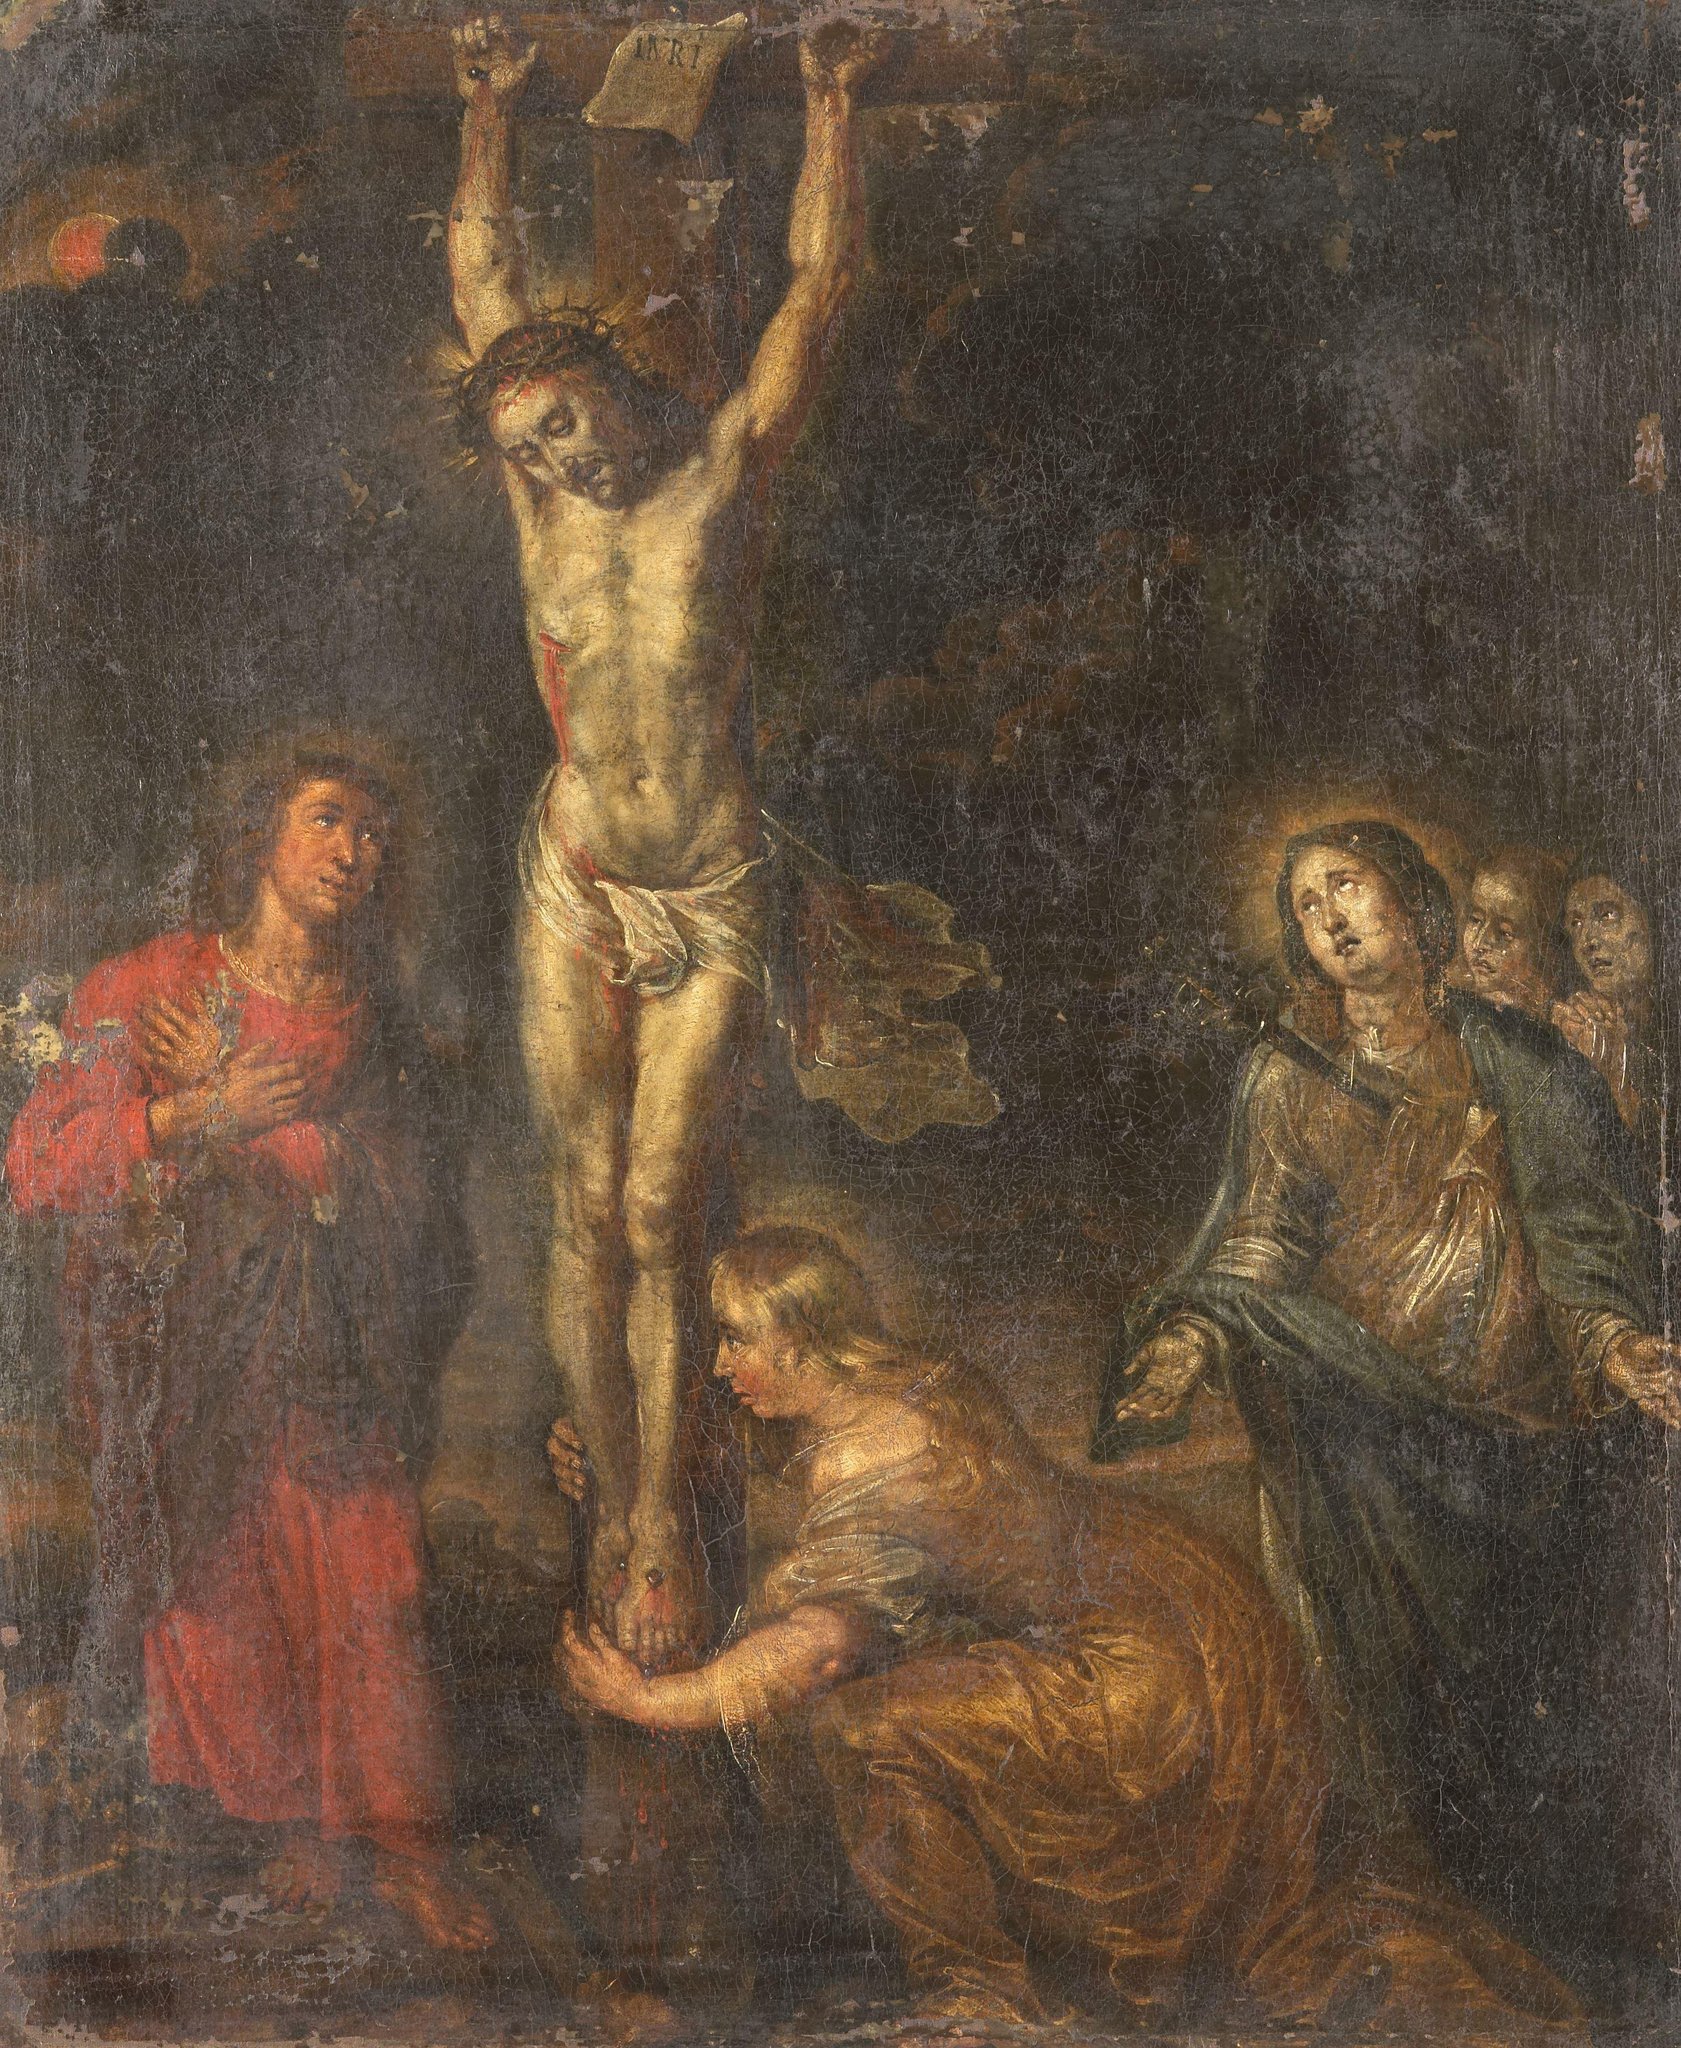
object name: centerpiece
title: Christ on the Cross, with the Mother of Sorrows and Saints John the Evangelist and Mary Magdalene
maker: Anonymous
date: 1630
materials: canvas, oil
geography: antwerp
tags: crucified christ with mary, john, and mary magdalene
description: Christus aan het kruis, links Johannes, rechts Maria met een zwaard door het hart. Maria Magdalena knielt bij de voet van het kruis. Waarschijnlijk een kopie. Verworven als middenpaneel met twee authentieke zijpanelen (zie SK-A-962-B/C).